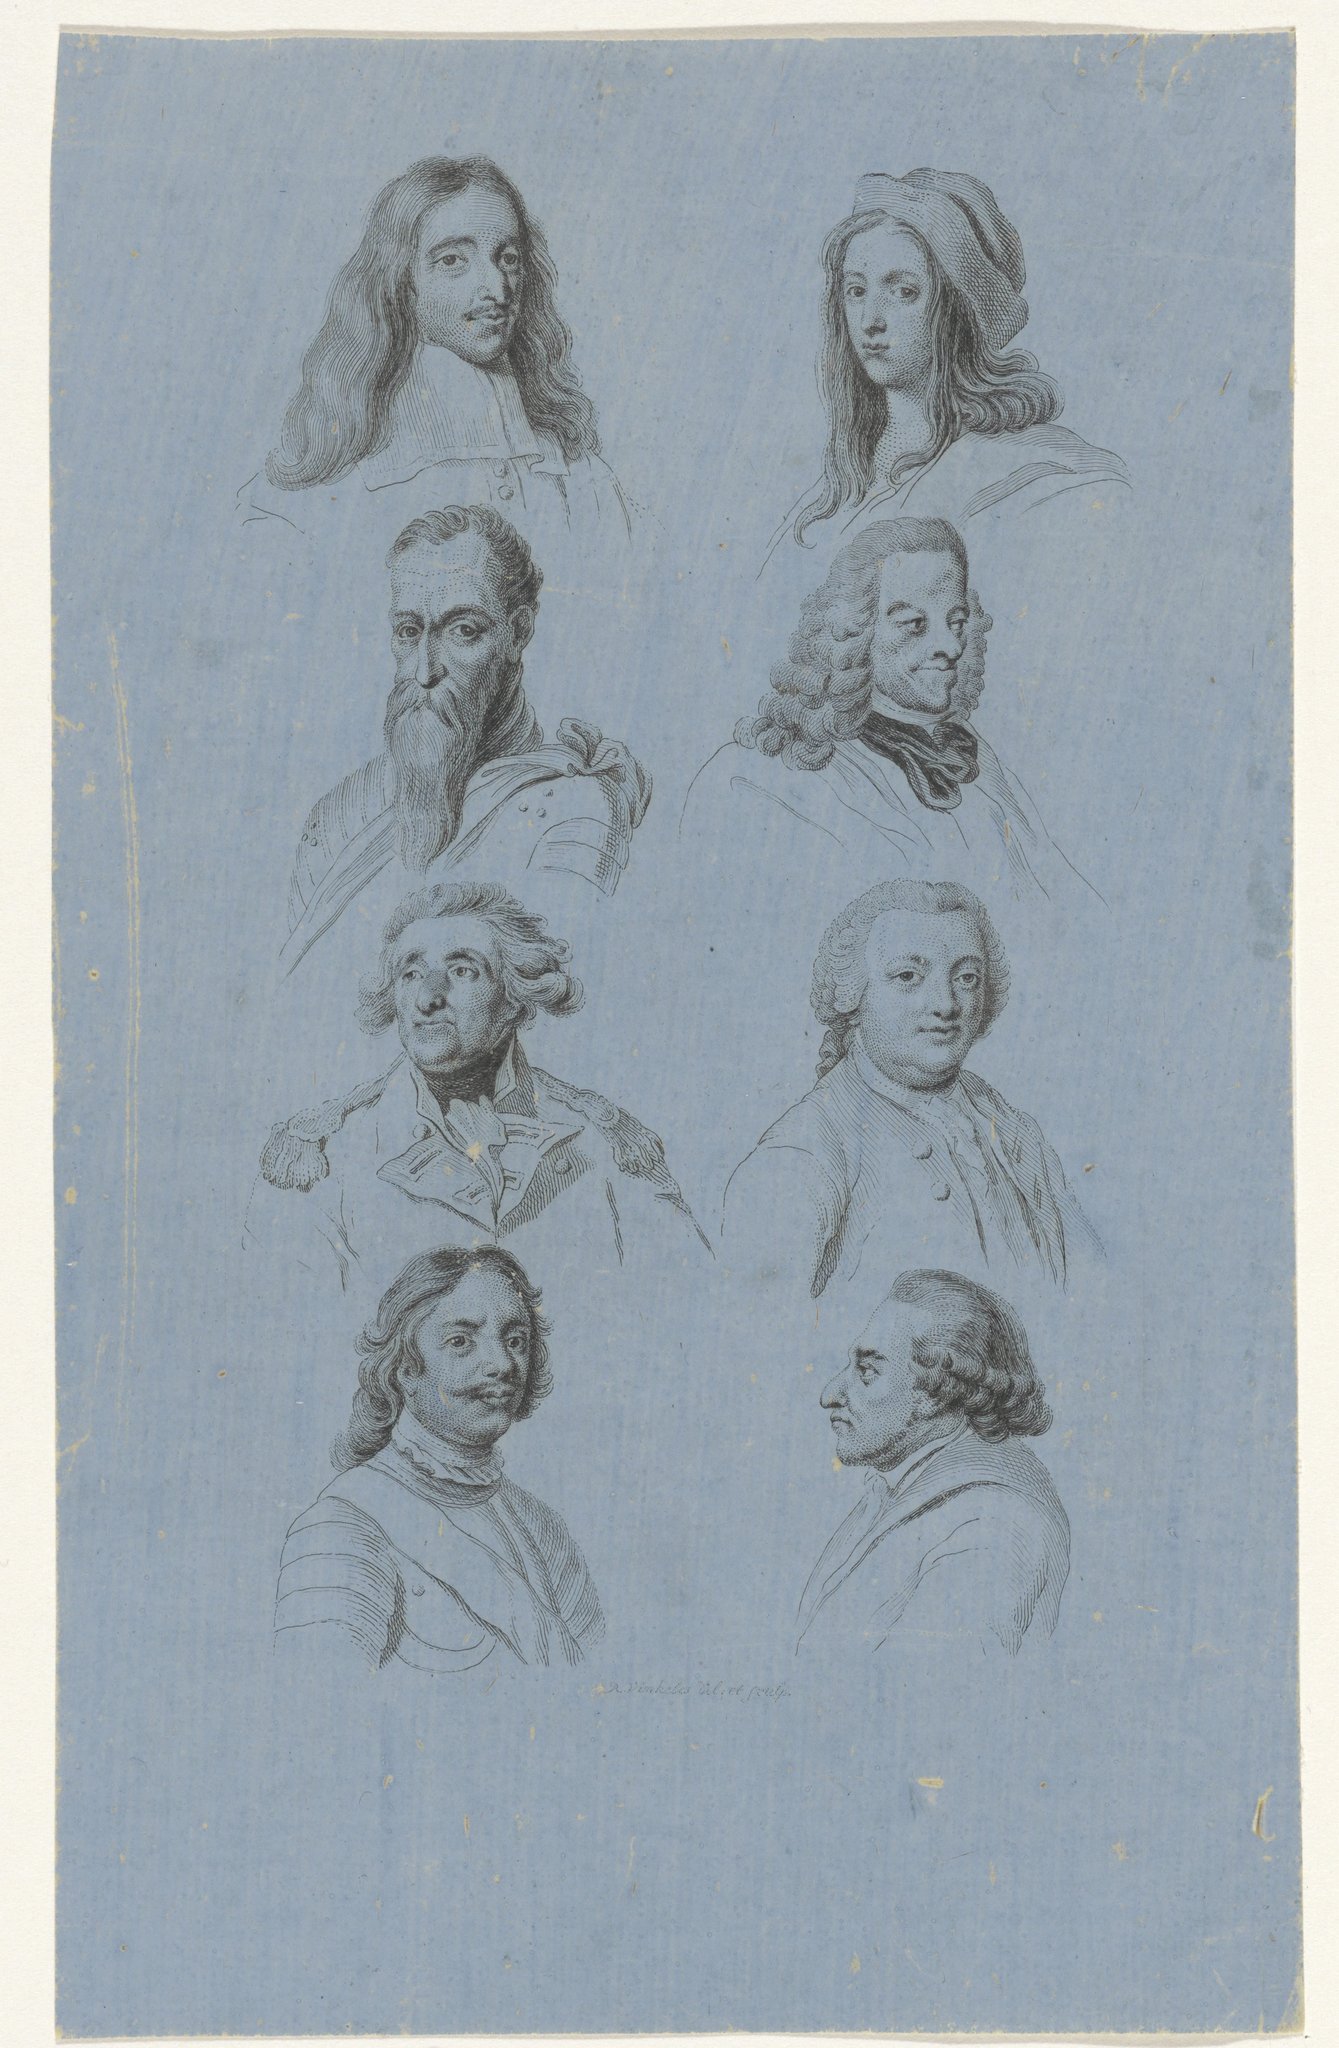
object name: print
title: Portretten van Portretten van acht historische figuren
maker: reinier vinkeles (i)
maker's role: draughtsman, print maker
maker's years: 1741-1816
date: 1751-1816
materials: paper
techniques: etching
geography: amsterdam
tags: rome, painter, rafaël, politician, johan de witt, fernando álvarez de toledo (3rd duke of alba), peter i de grote (tsaar van rusland), berlin, leiden, vienna, paris, voltaire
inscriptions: collector's mark: Lugt 2228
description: Portretten van de advocaat Johan de Witt, de schilder Rafaël, de hertog van Alva, de schrijver Voltaire, baron Heathfield, mogelijk Gerard baron Van Swieten, Peter de Grote, tsaar van Rusland en de filosoof Moses Mendelssohn.